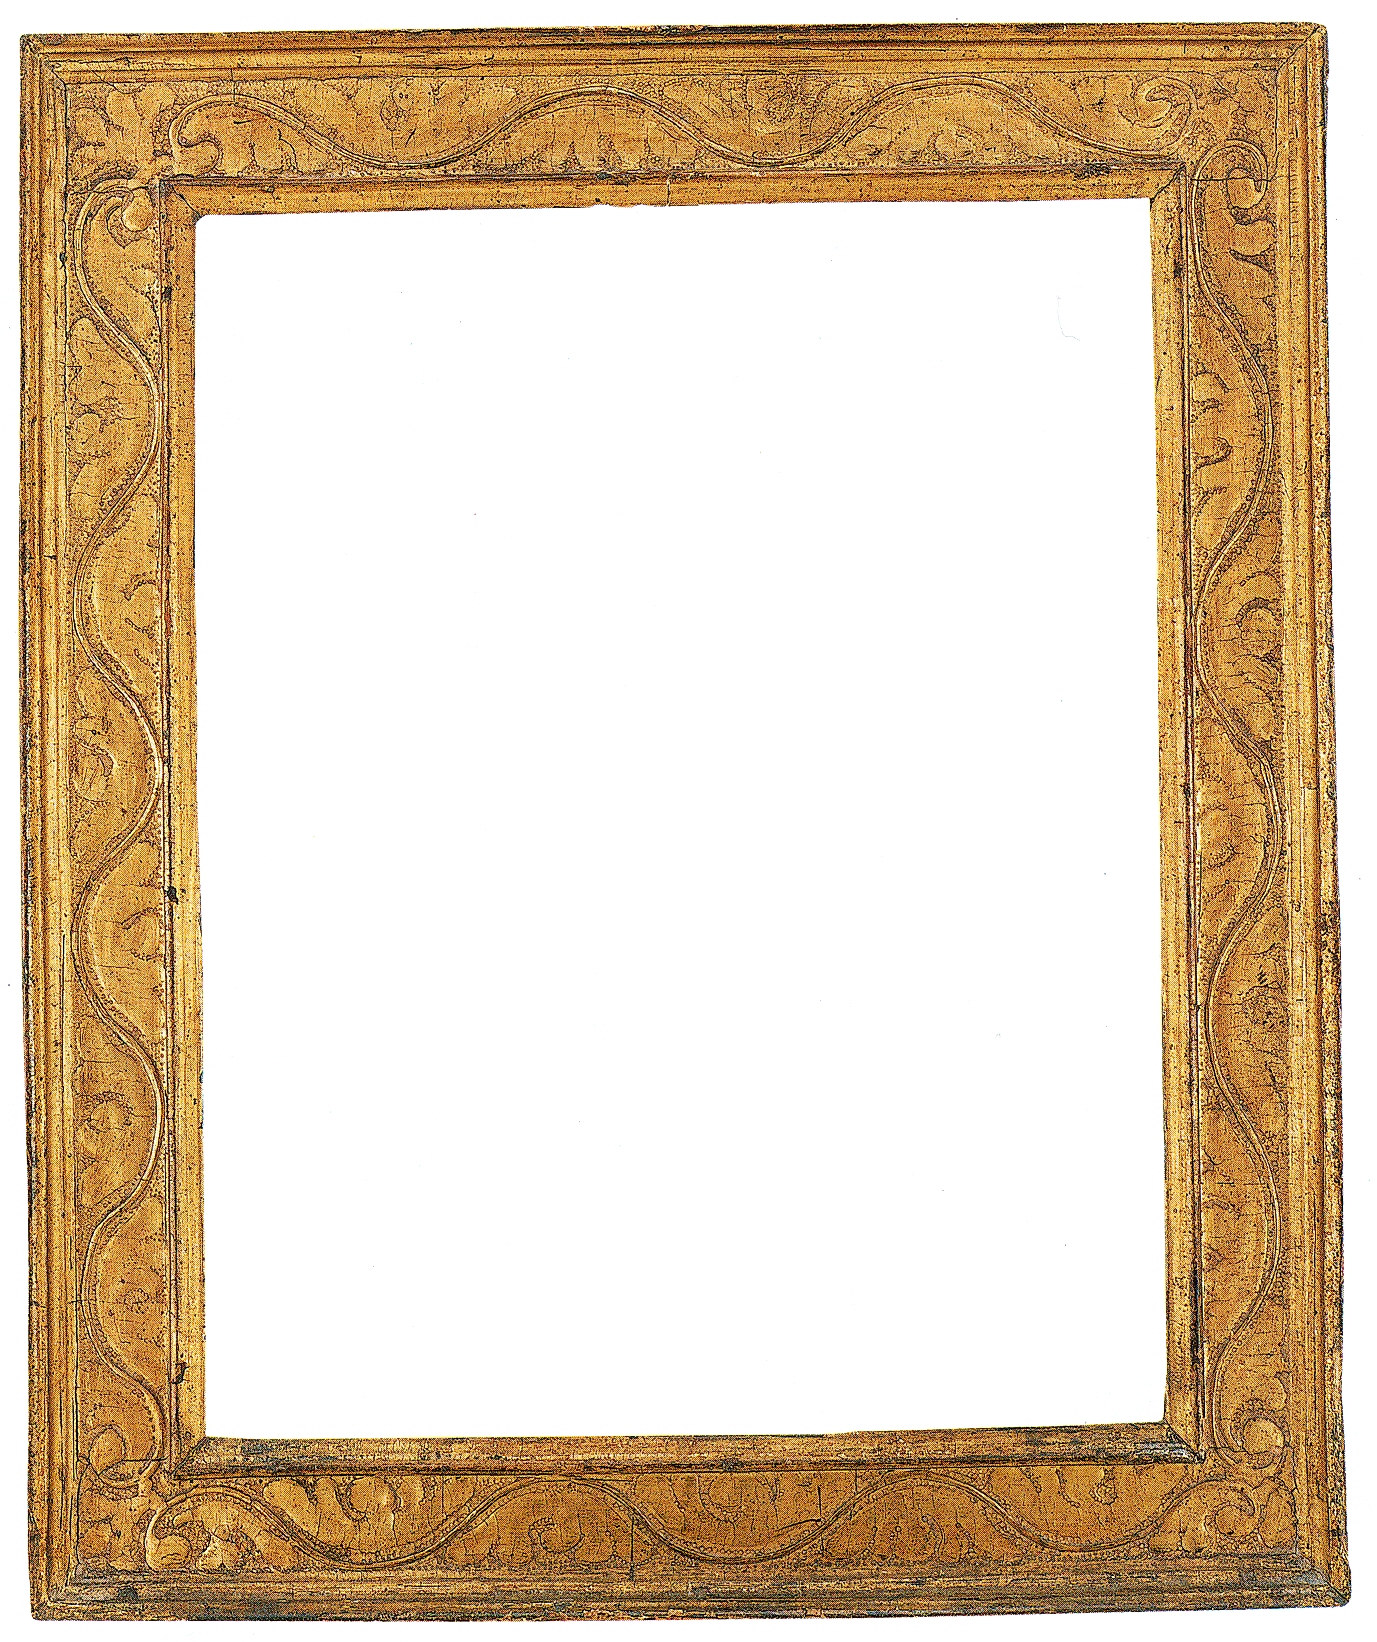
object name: frame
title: Cassetta frame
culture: italian, lombardy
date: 1601-1633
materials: wood